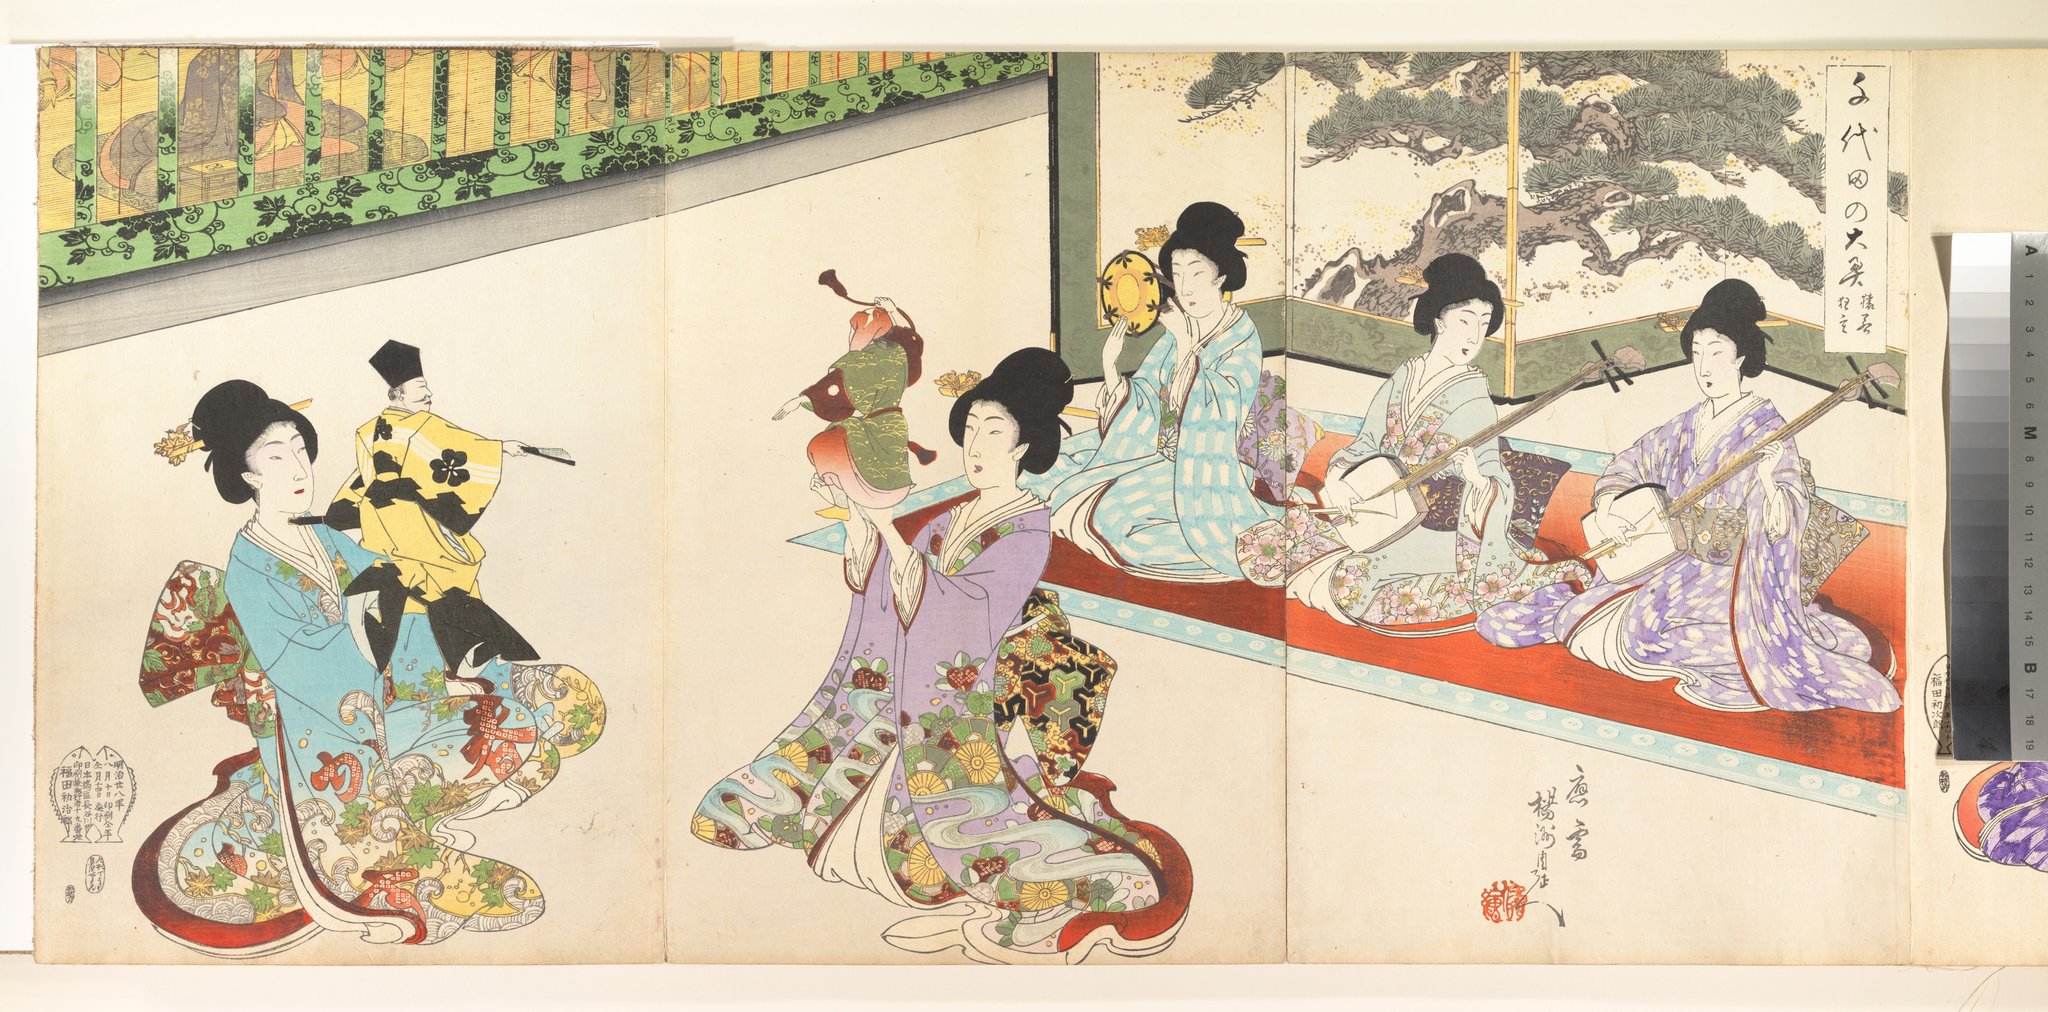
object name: print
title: Ladies in Waiting of the Chiyoda Castle: Sword Practice and Puppet Kyōgen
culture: japanese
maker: yōshū (hashimoto) chikanobu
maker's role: artist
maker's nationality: japanese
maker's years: 1838-1912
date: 1895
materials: ink, paper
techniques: woodblock print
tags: musical instruments,women,musicians,puppets